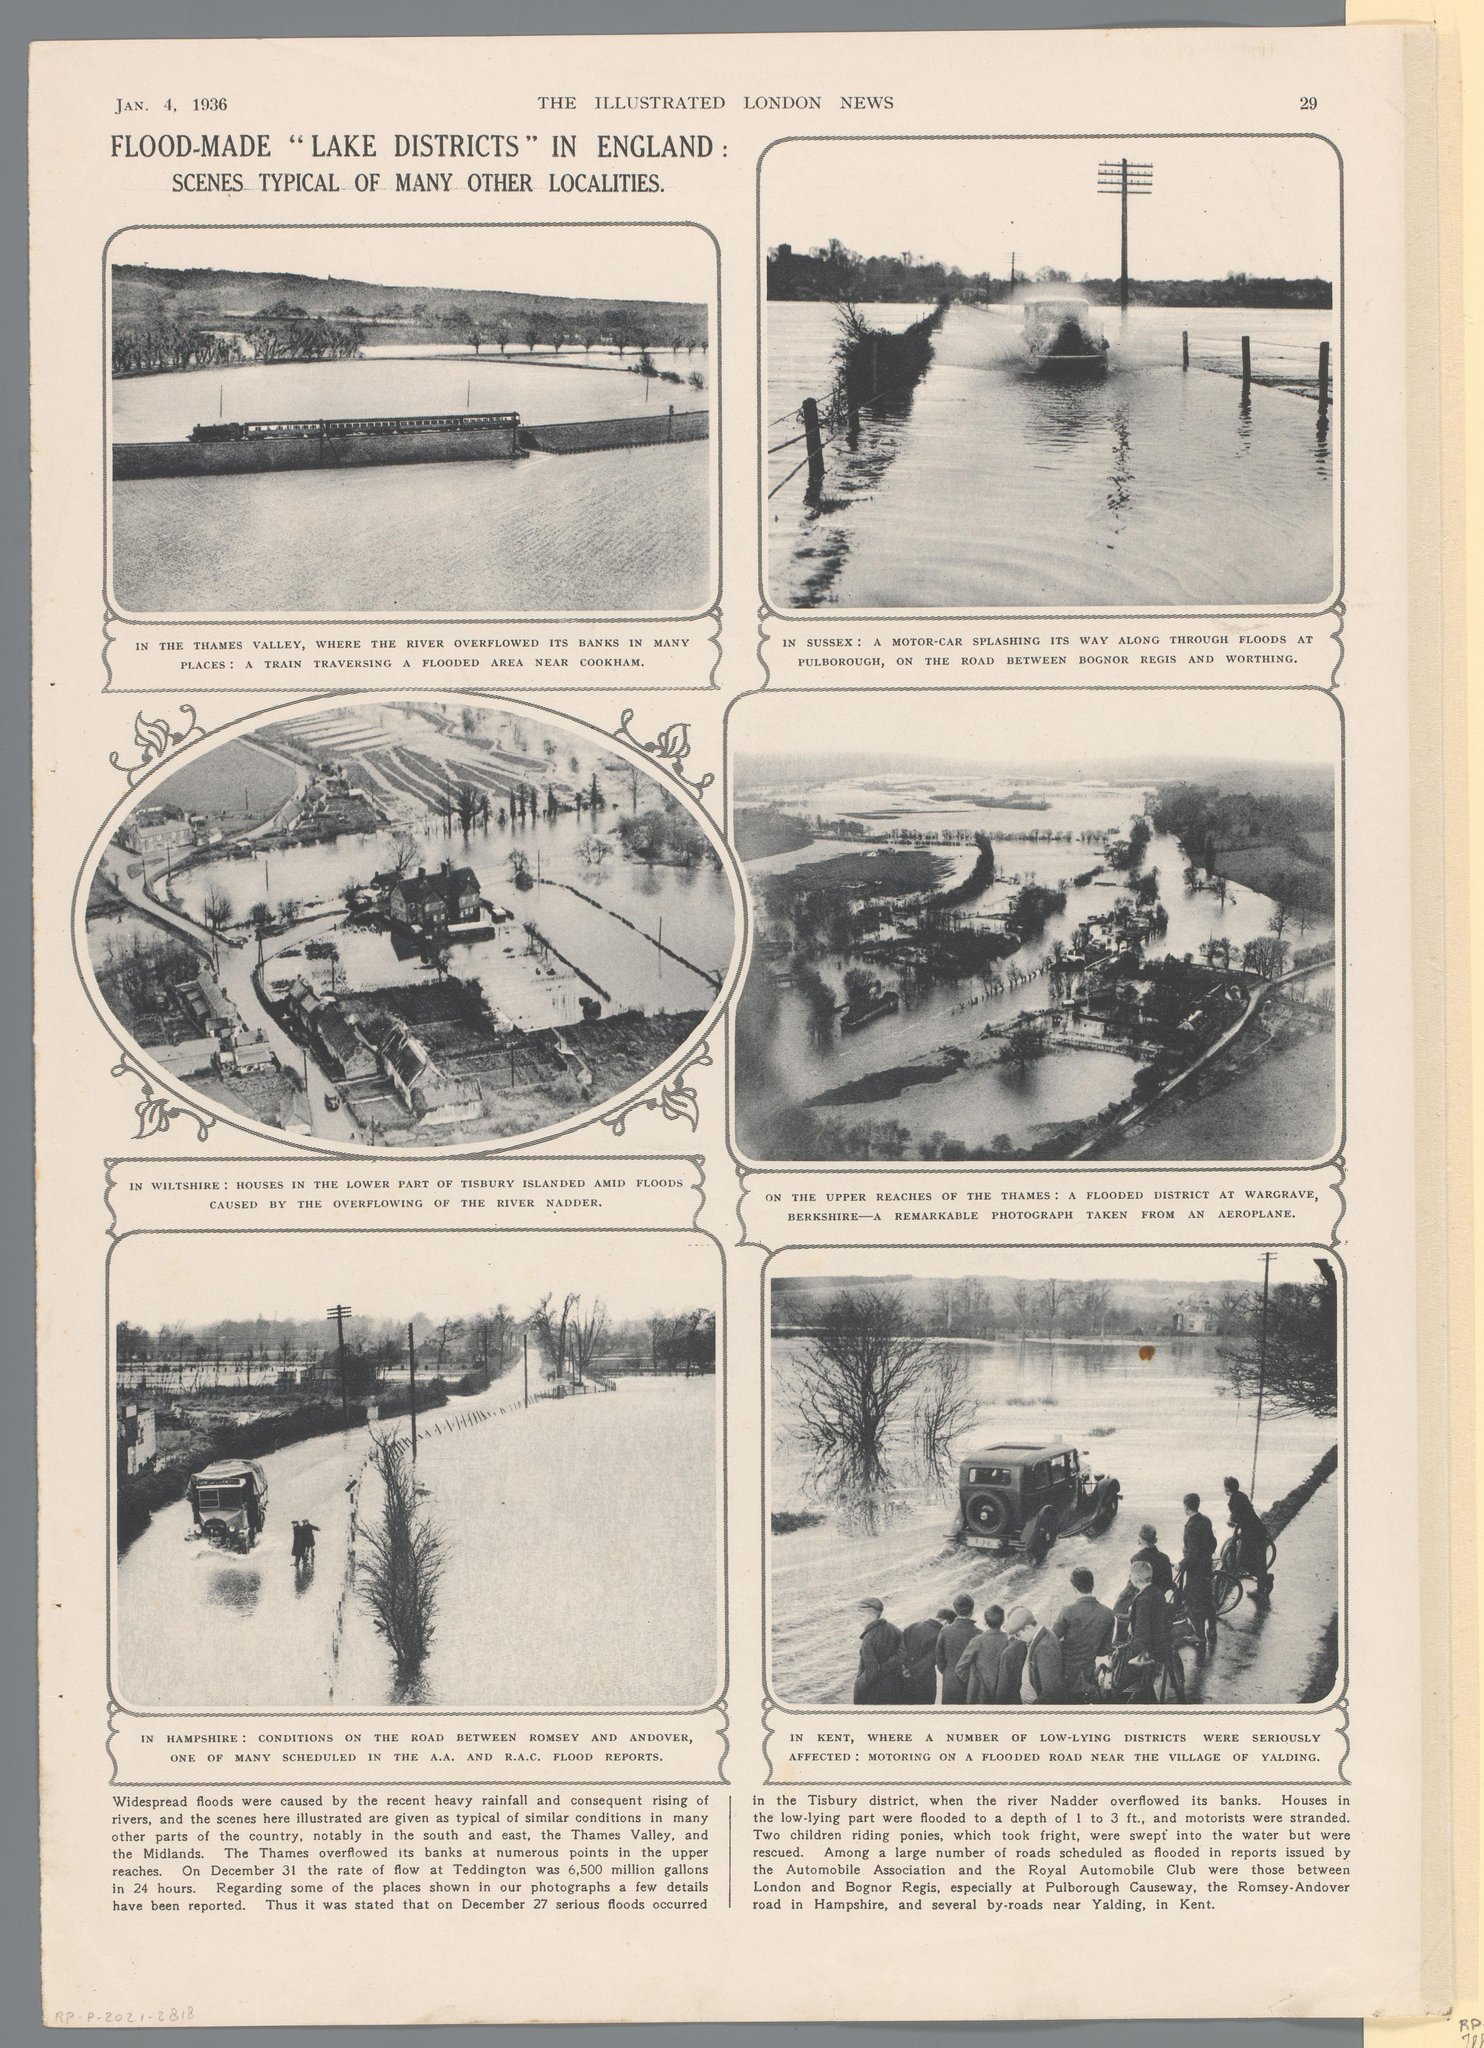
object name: photomechanical print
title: Flood-Made "Lake Districts" in England: scenes typical of many other localities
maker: Anonymous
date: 1936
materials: paper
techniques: printing, rotogravure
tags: city-view, and landscape with man-made constructions, flood, england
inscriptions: date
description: Pagina uit: The Illustrated London News, 4 januari 1936, p. 30.